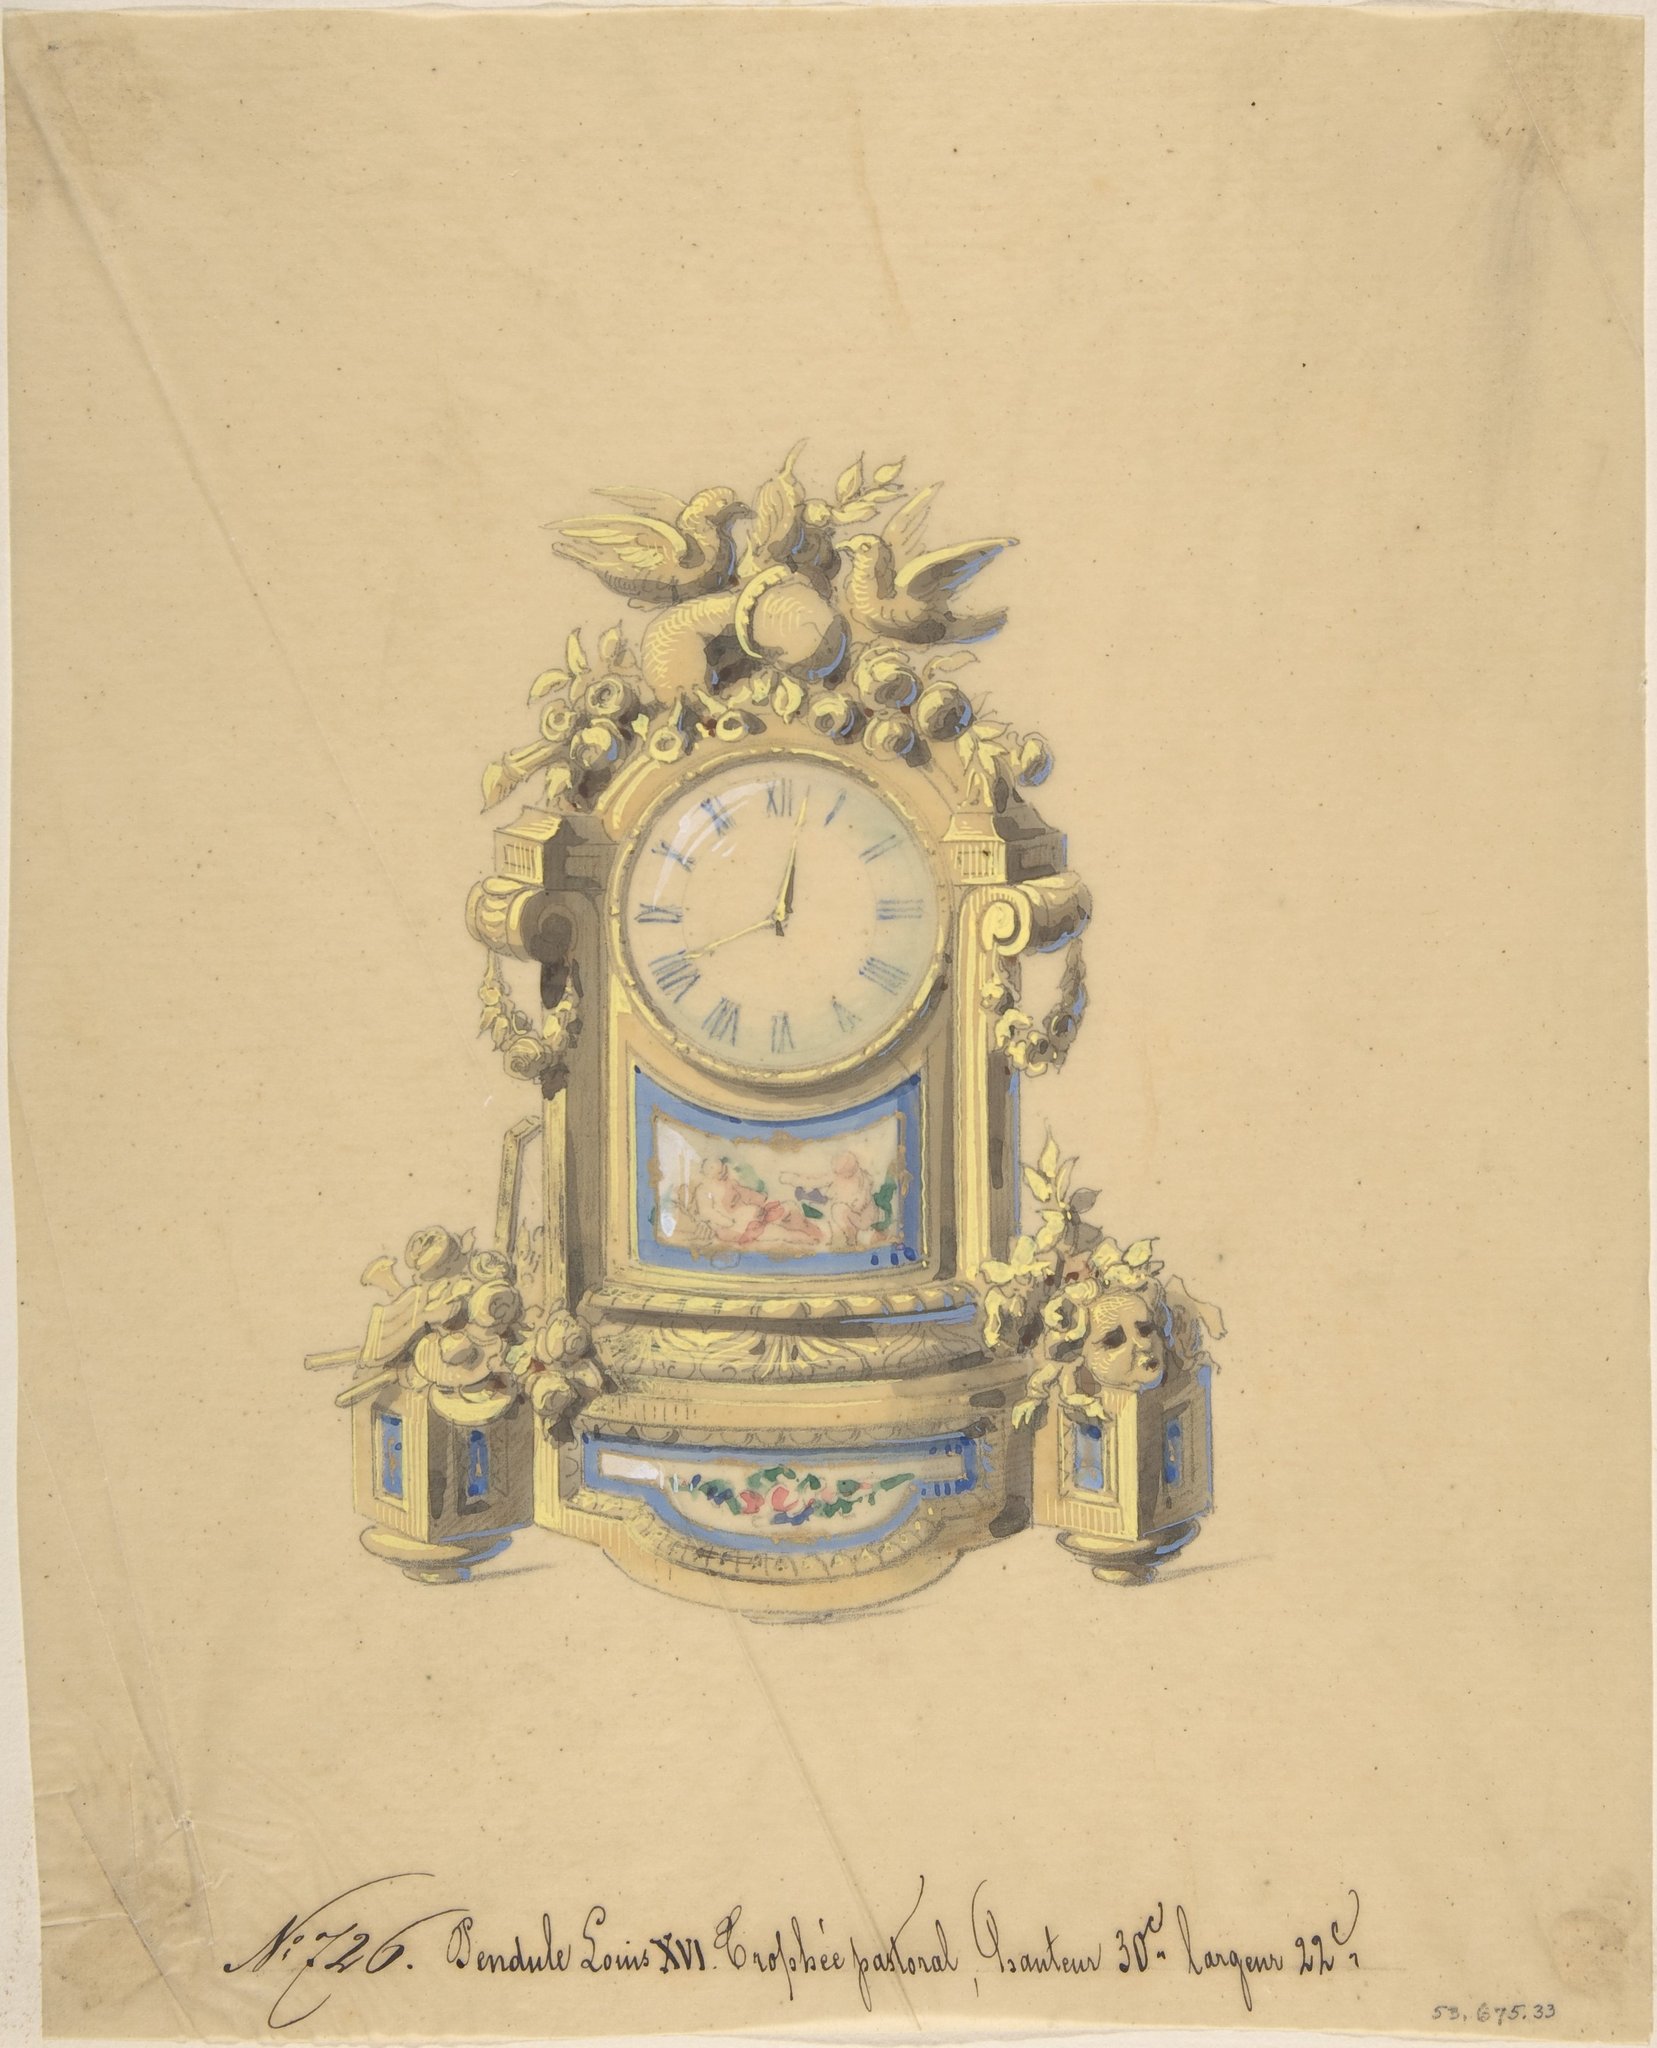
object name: drawing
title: Design for a Clock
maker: anonymous, french, 19th century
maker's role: artist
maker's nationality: french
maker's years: 1800-1900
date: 1801-1900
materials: gouache, graphite, ink, watercolor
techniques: pen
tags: clocks